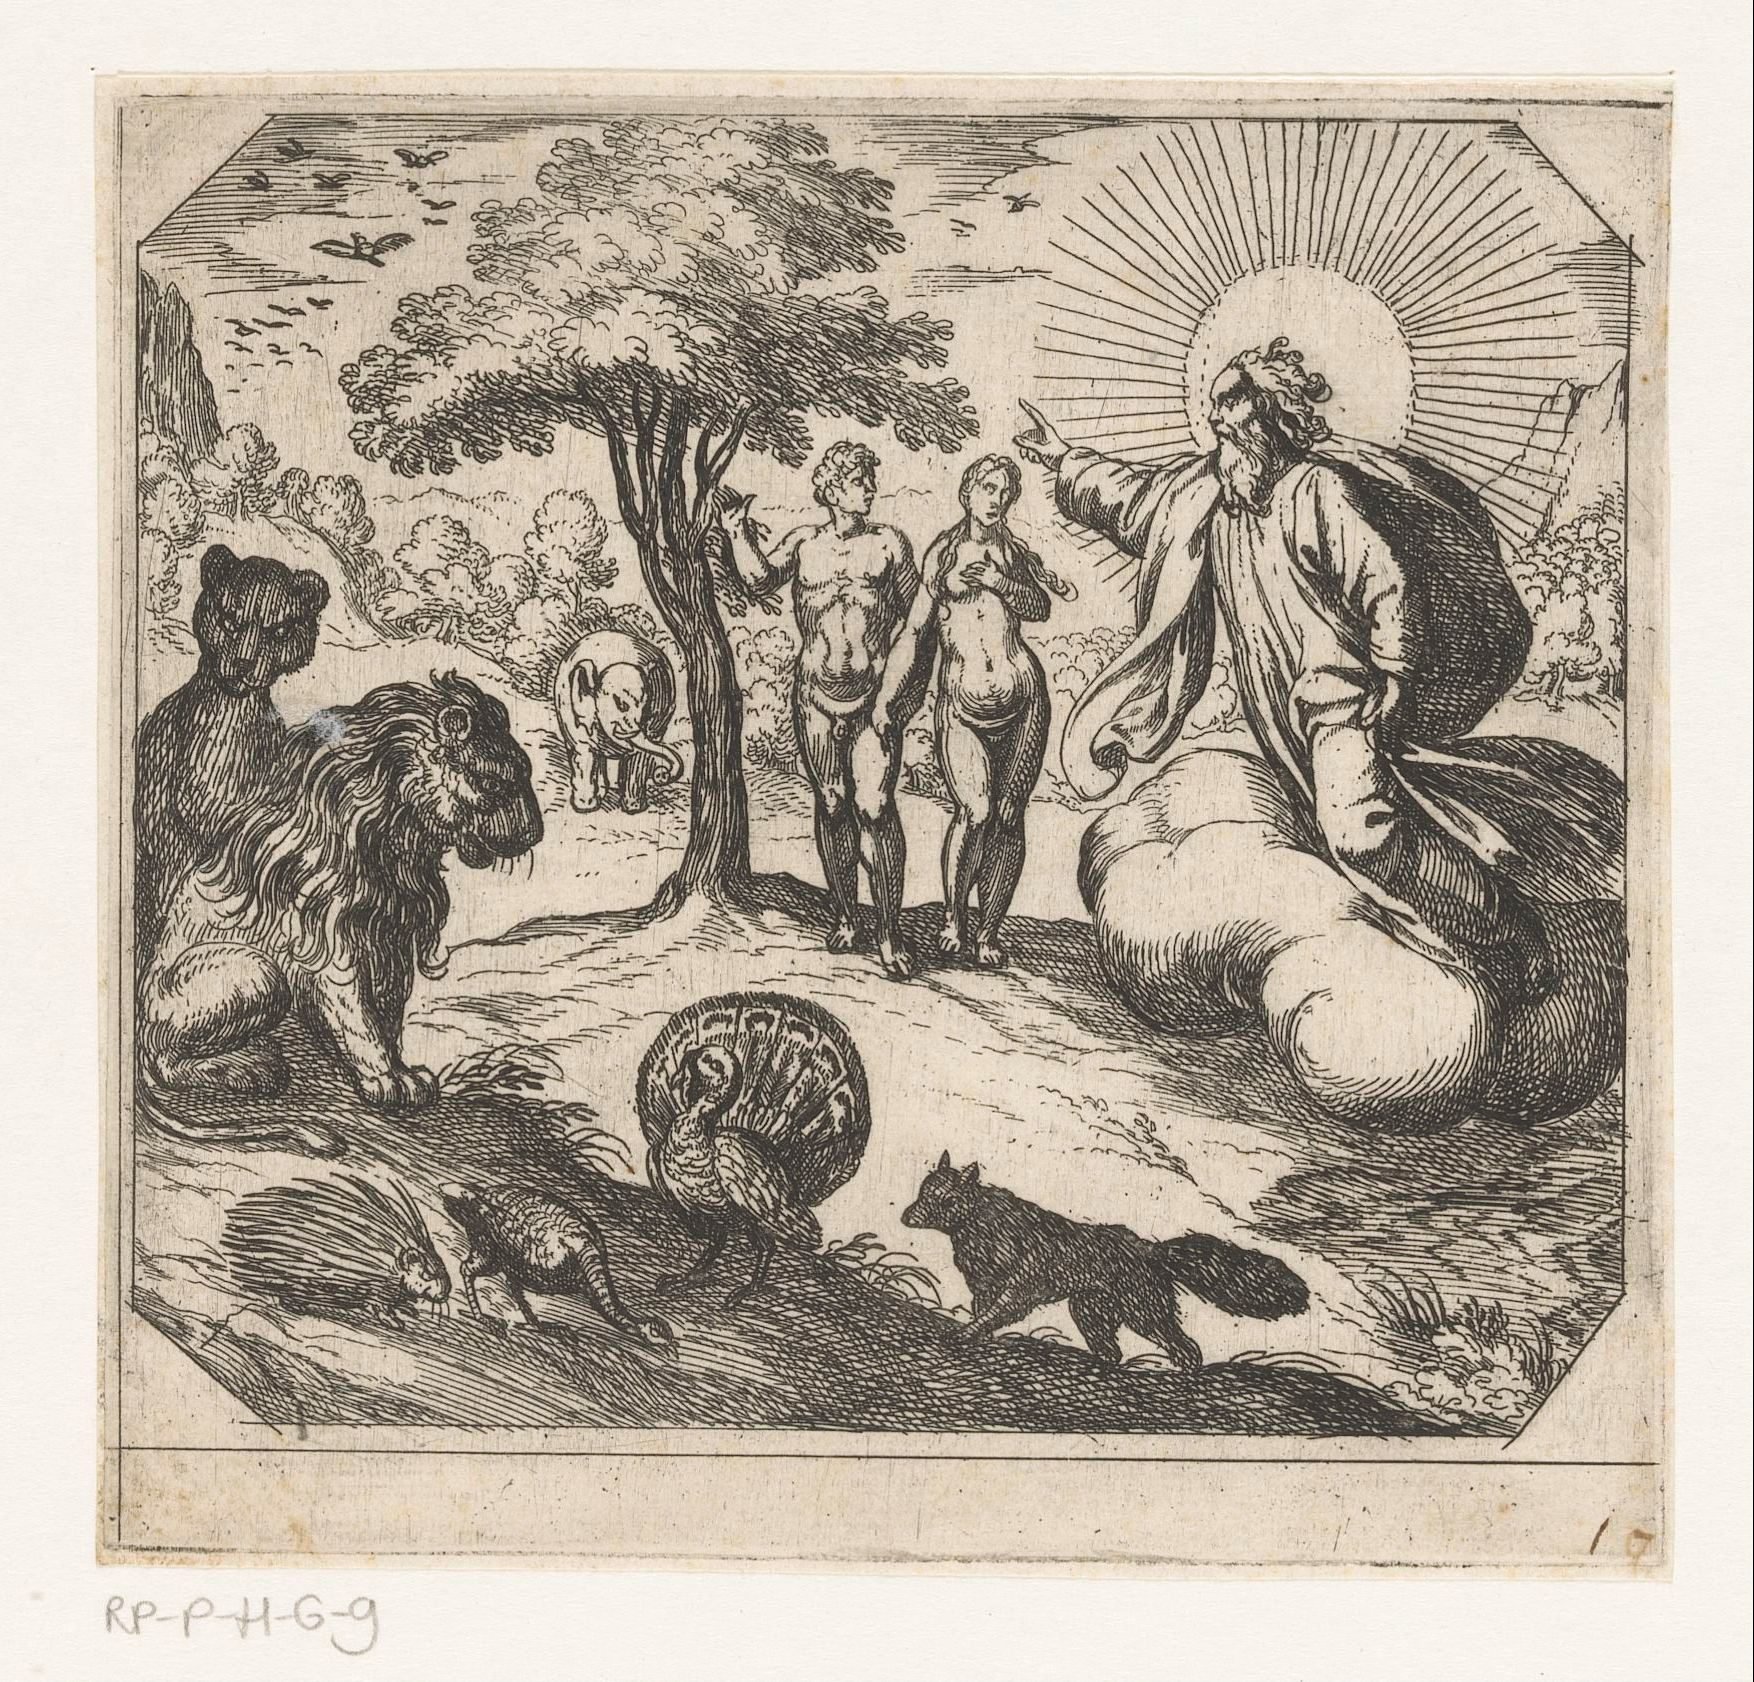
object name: print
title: De schepping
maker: antonio tempesta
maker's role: draughtsman, painter, print maker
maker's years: 1555-1630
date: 1565-1630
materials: paper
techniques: etching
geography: rome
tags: the giving of the test commandment: god warns adam and eve not to eat from the tree of knowledge of good and evil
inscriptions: number: ‘10’, collector's mark: ‘Hinloopen’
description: Deze prent maakt deel uit van een serie van twaalf prenten van de schepping. De prenten zijn deels naar ontwerpen van Rafaël voor de Loggia van Rafaël in het Vaticaan, en deels naar prenten door Nicolaes de Bruyn naar ontwerpen van Maerten de Vos (zie: Holl. Dutch. vol. 45 nr. 1-10).